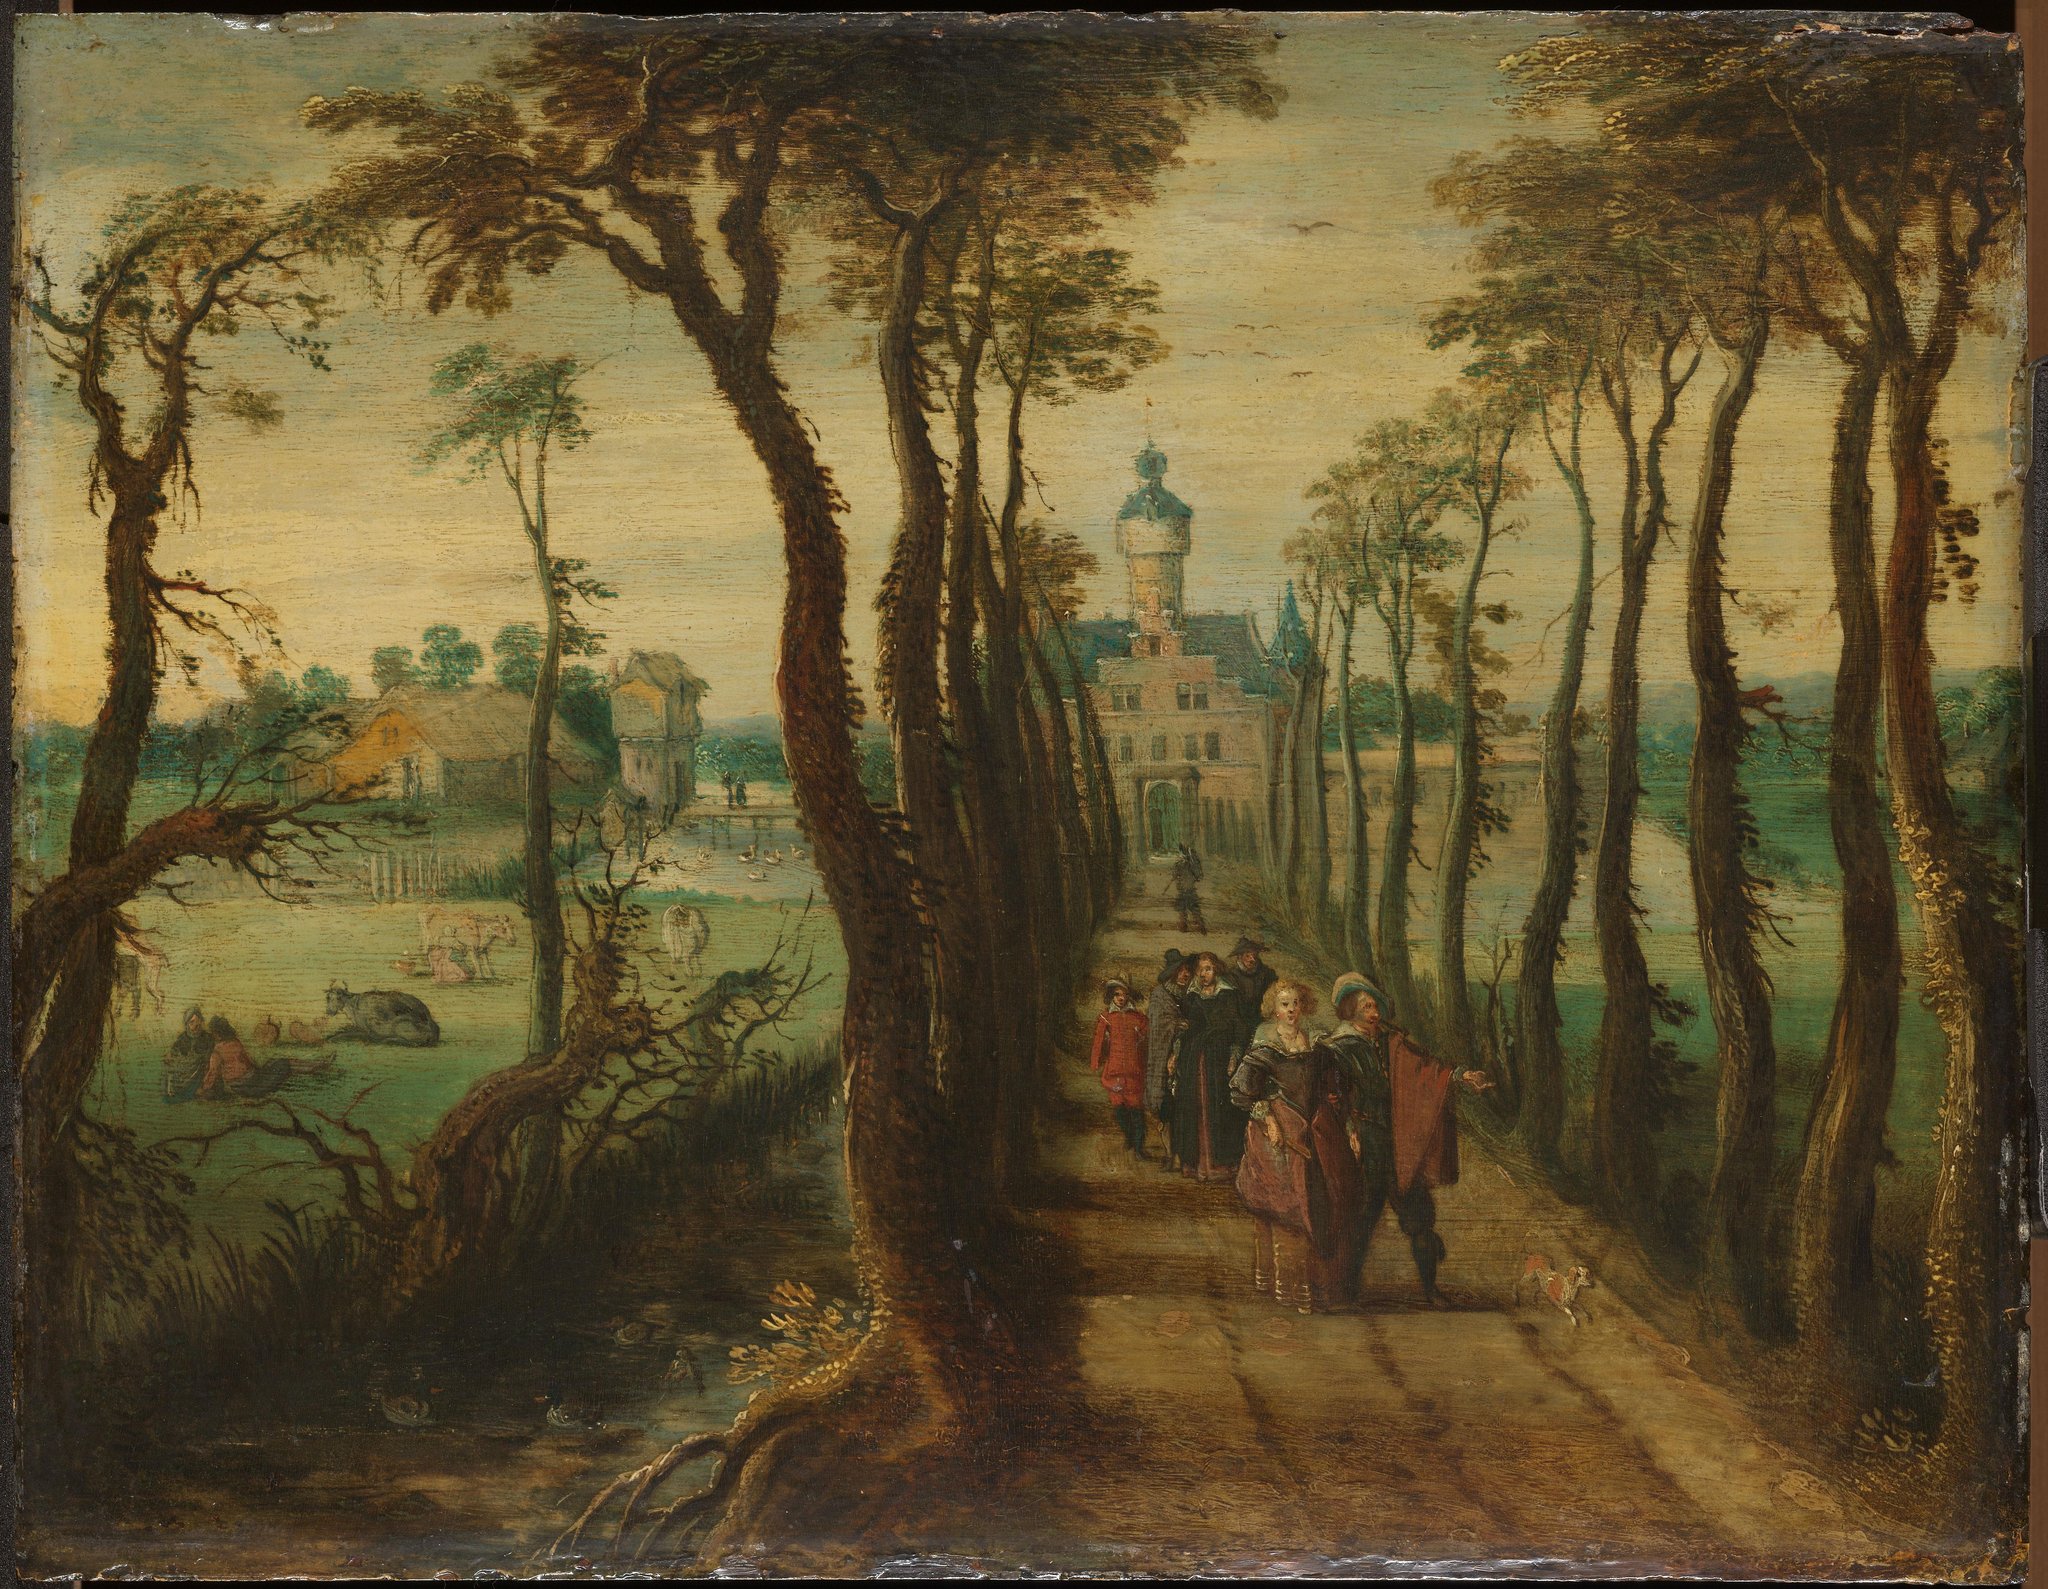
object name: painting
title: Elegant Company on a Causeway Leading towards a Country-House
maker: Anonymous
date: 1650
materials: oil, panel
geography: southern netherlands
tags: castle, rural housing, e.g. country-house, villa, cottage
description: Een elegant gezelschap wandelt over de oprijlaan van een landhuis. Aan weerszijden van de laan staan rijen bomen. Links een weiland met koeien en boeren.